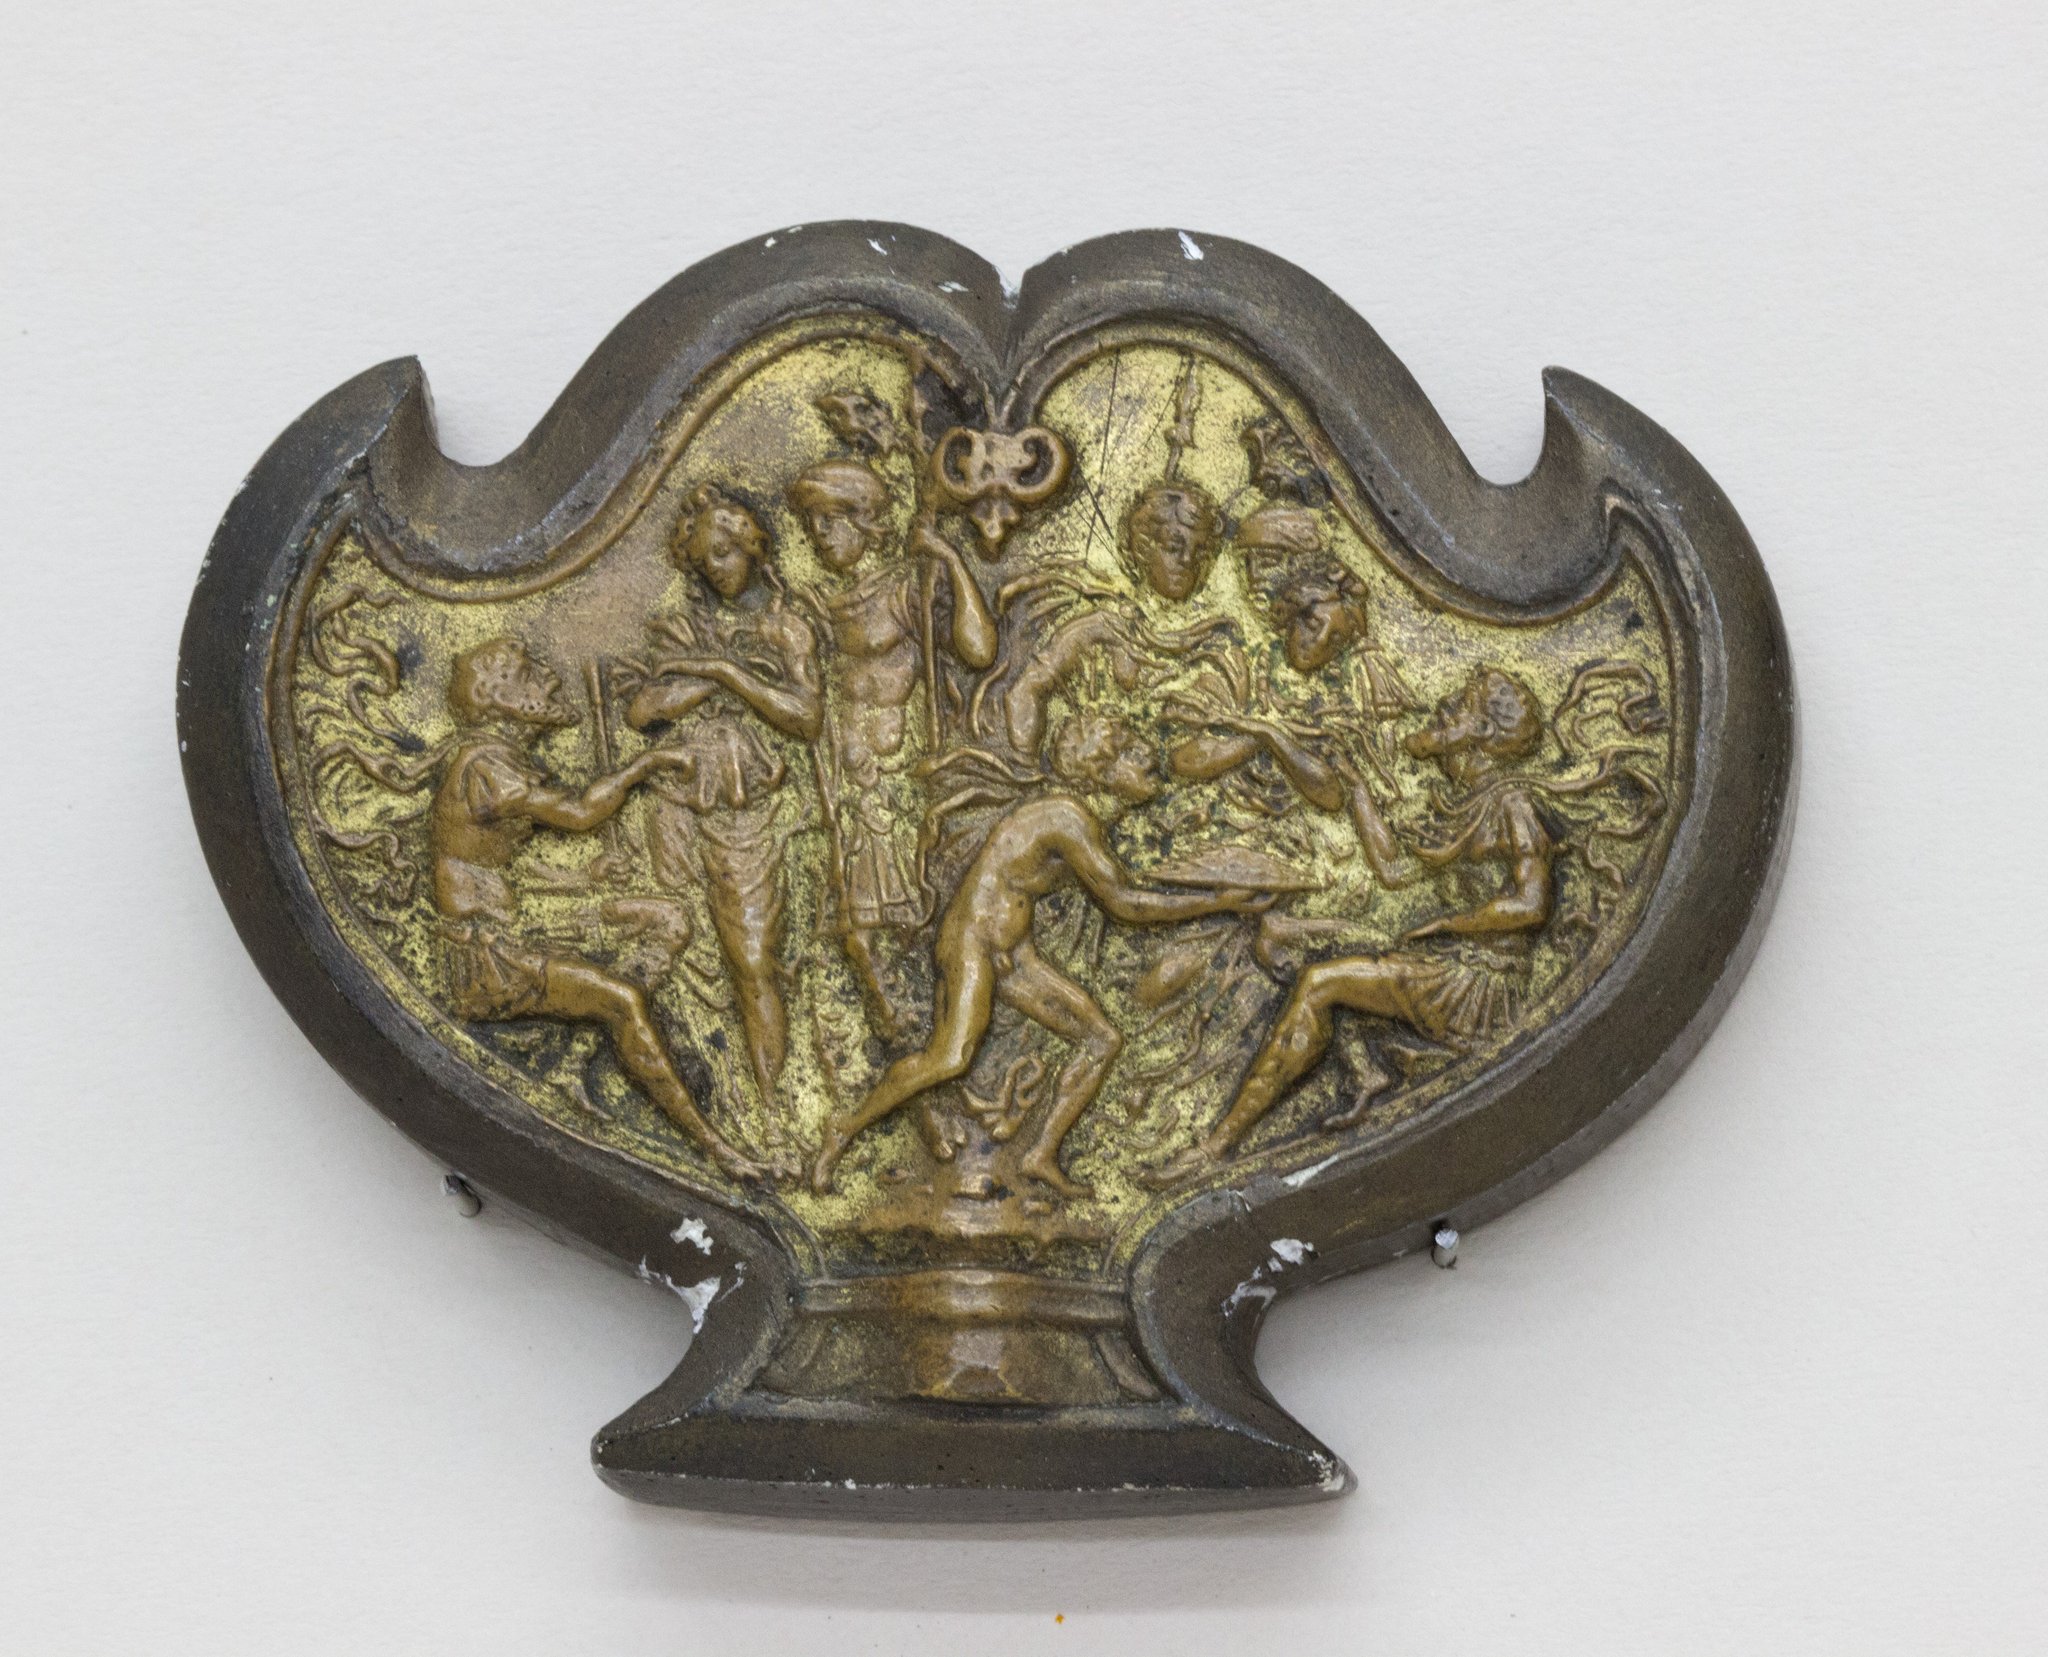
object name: plaque of sword pommel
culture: italian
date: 1500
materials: bronze, gold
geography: italy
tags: men,male nudes,women